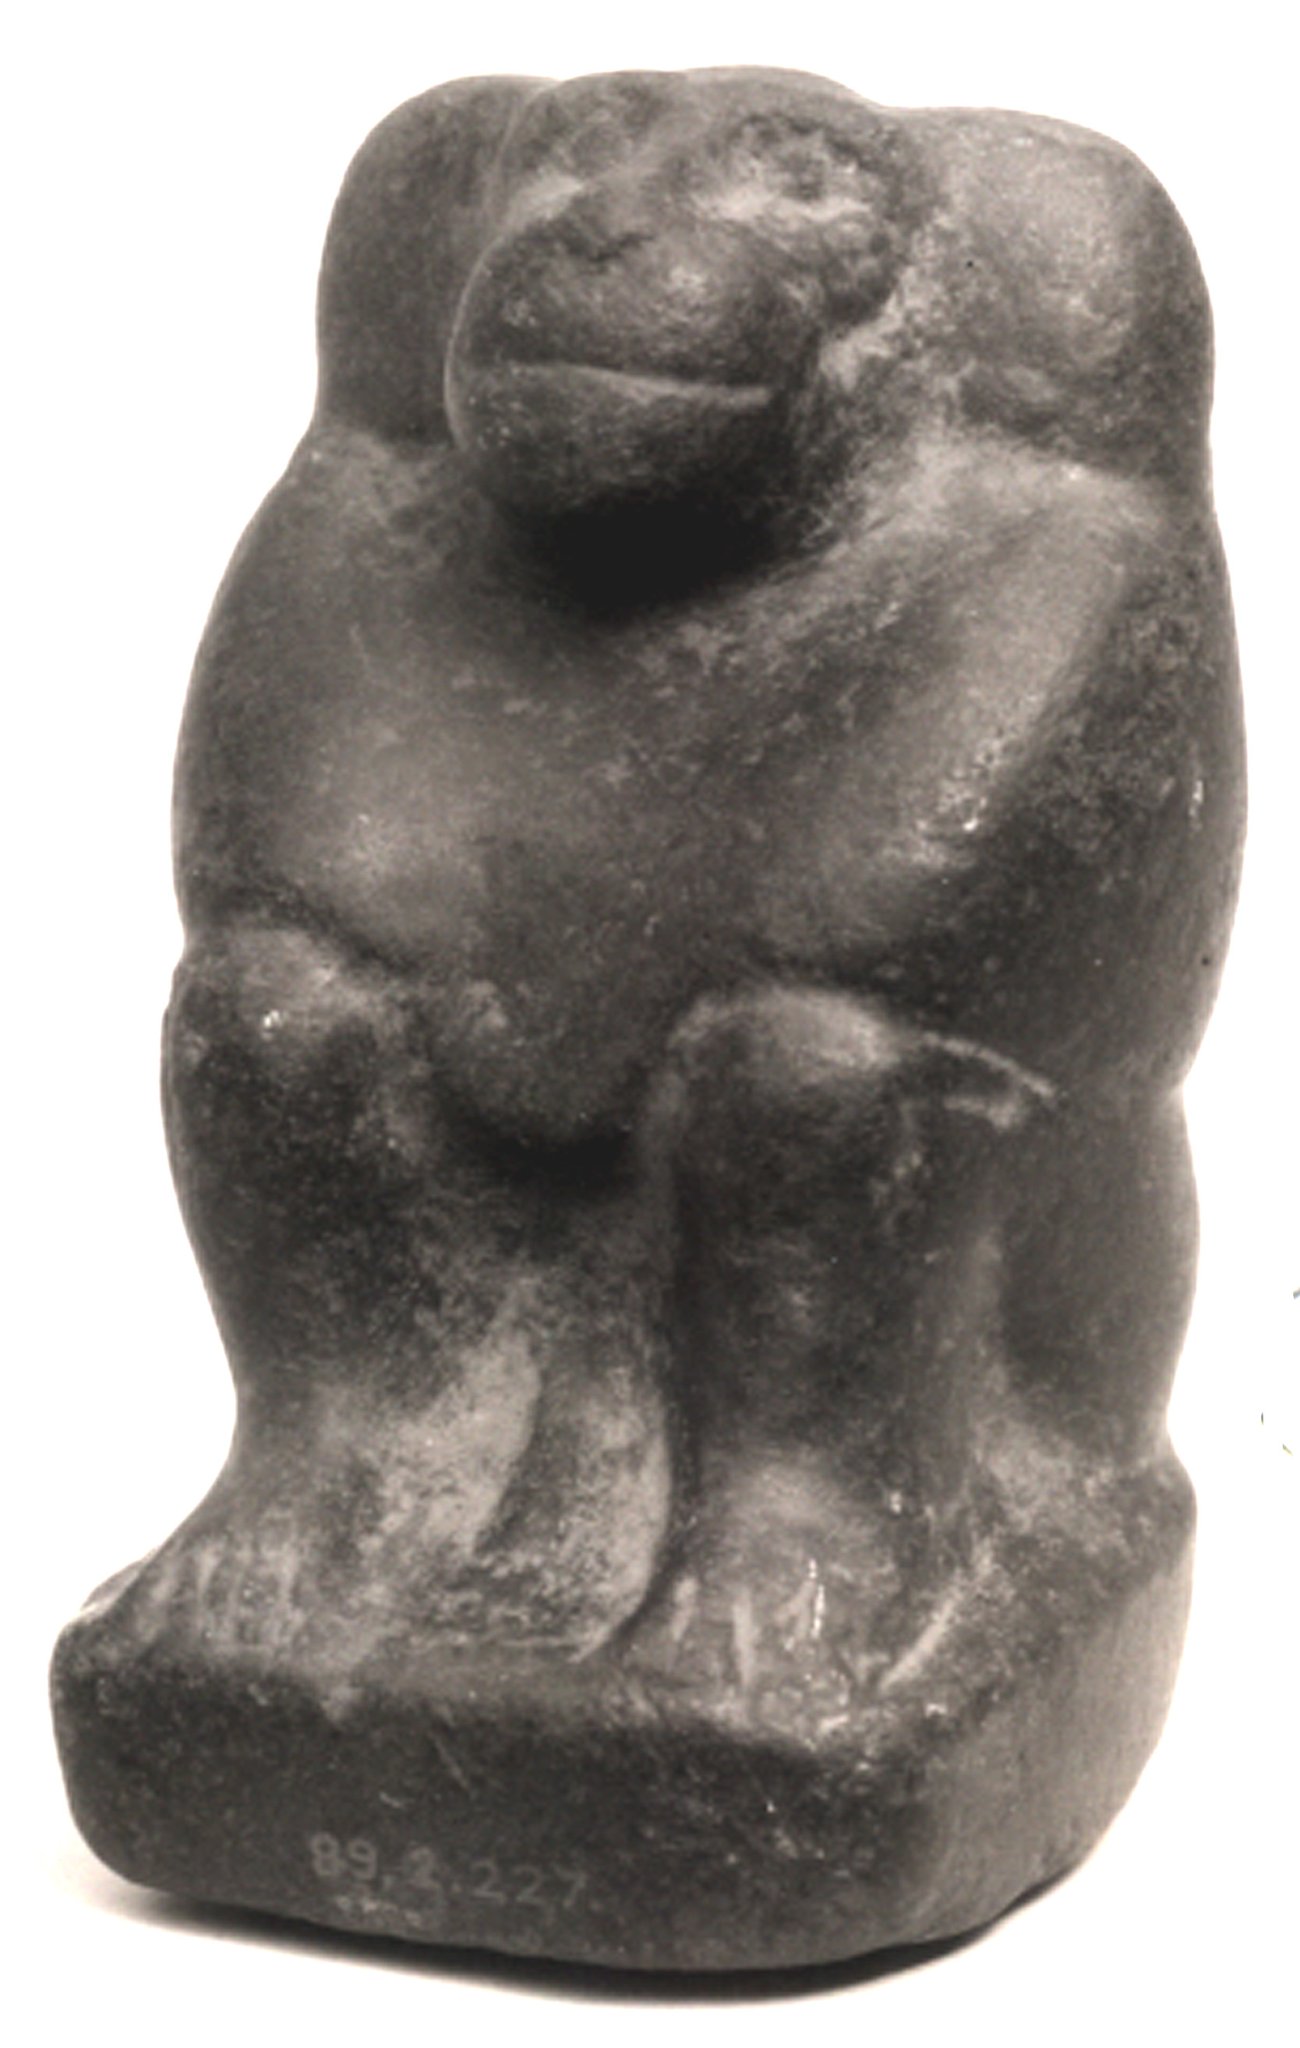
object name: figurine, ape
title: Ape figurine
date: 1353-1323 BCE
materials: stone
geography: egypt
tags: monkeys